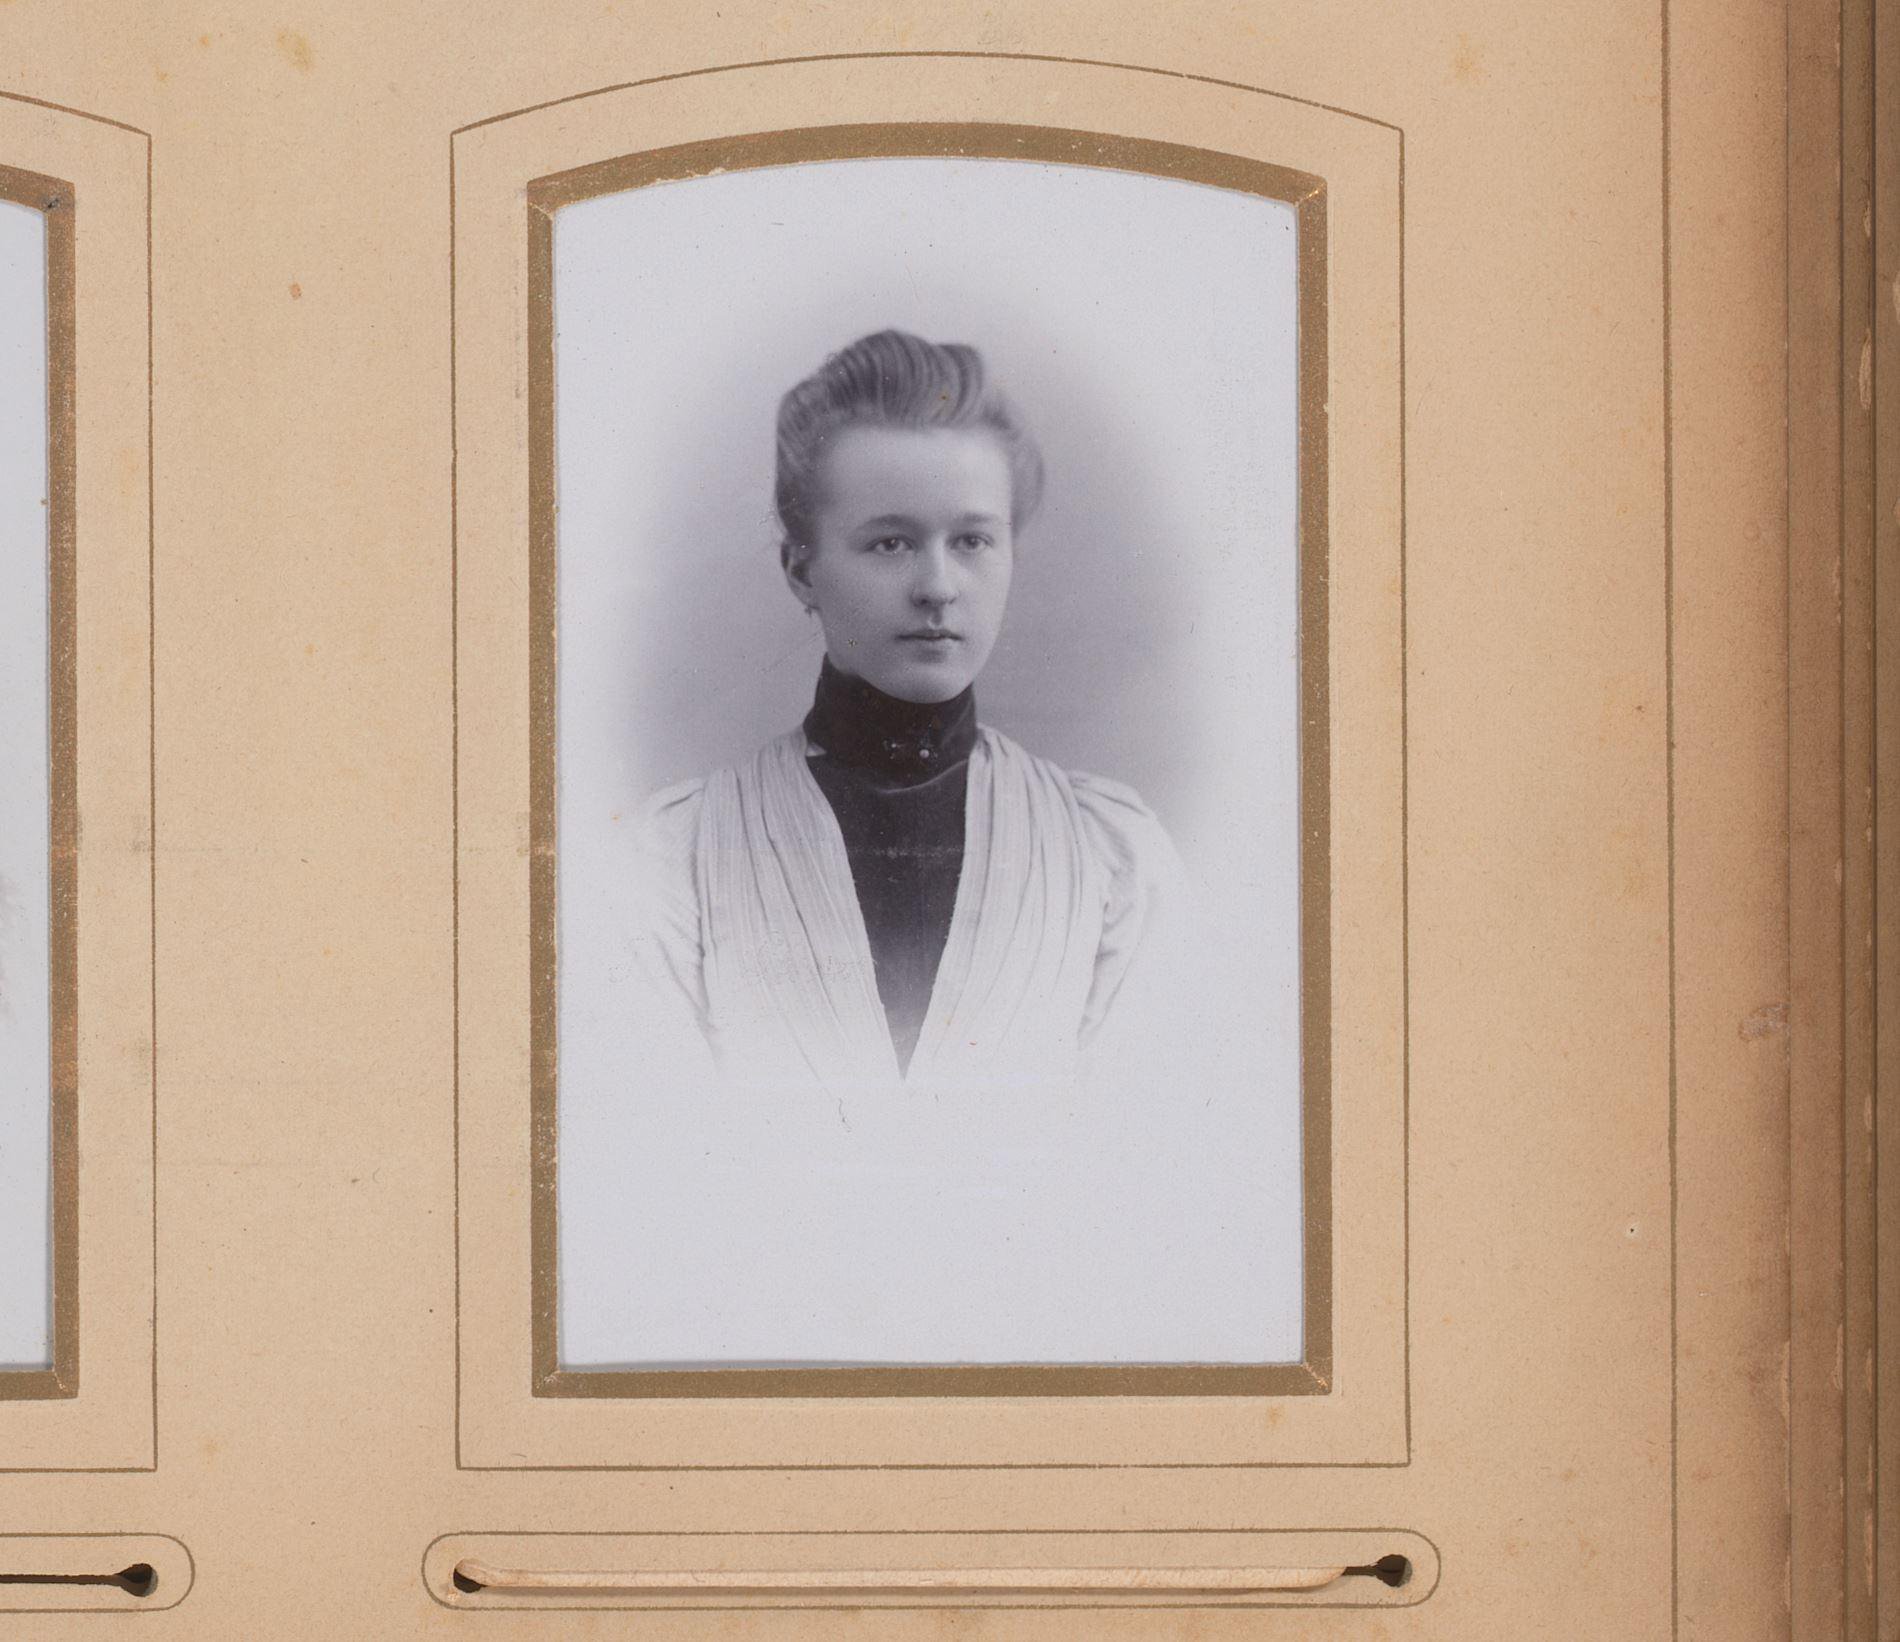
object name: carte de visite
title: Portret van een meisje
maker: max cosman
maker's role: fotograaf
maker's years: 1852-1894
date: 1881-1903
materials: cardboard, photographic support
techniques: collodion silver print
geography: amsterdam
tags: historical persons - bb - woman, girl (child between toddler and youth)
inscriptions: inscription: ‘Max Cosman. AMSTERDAM,/ Galerij 48.’